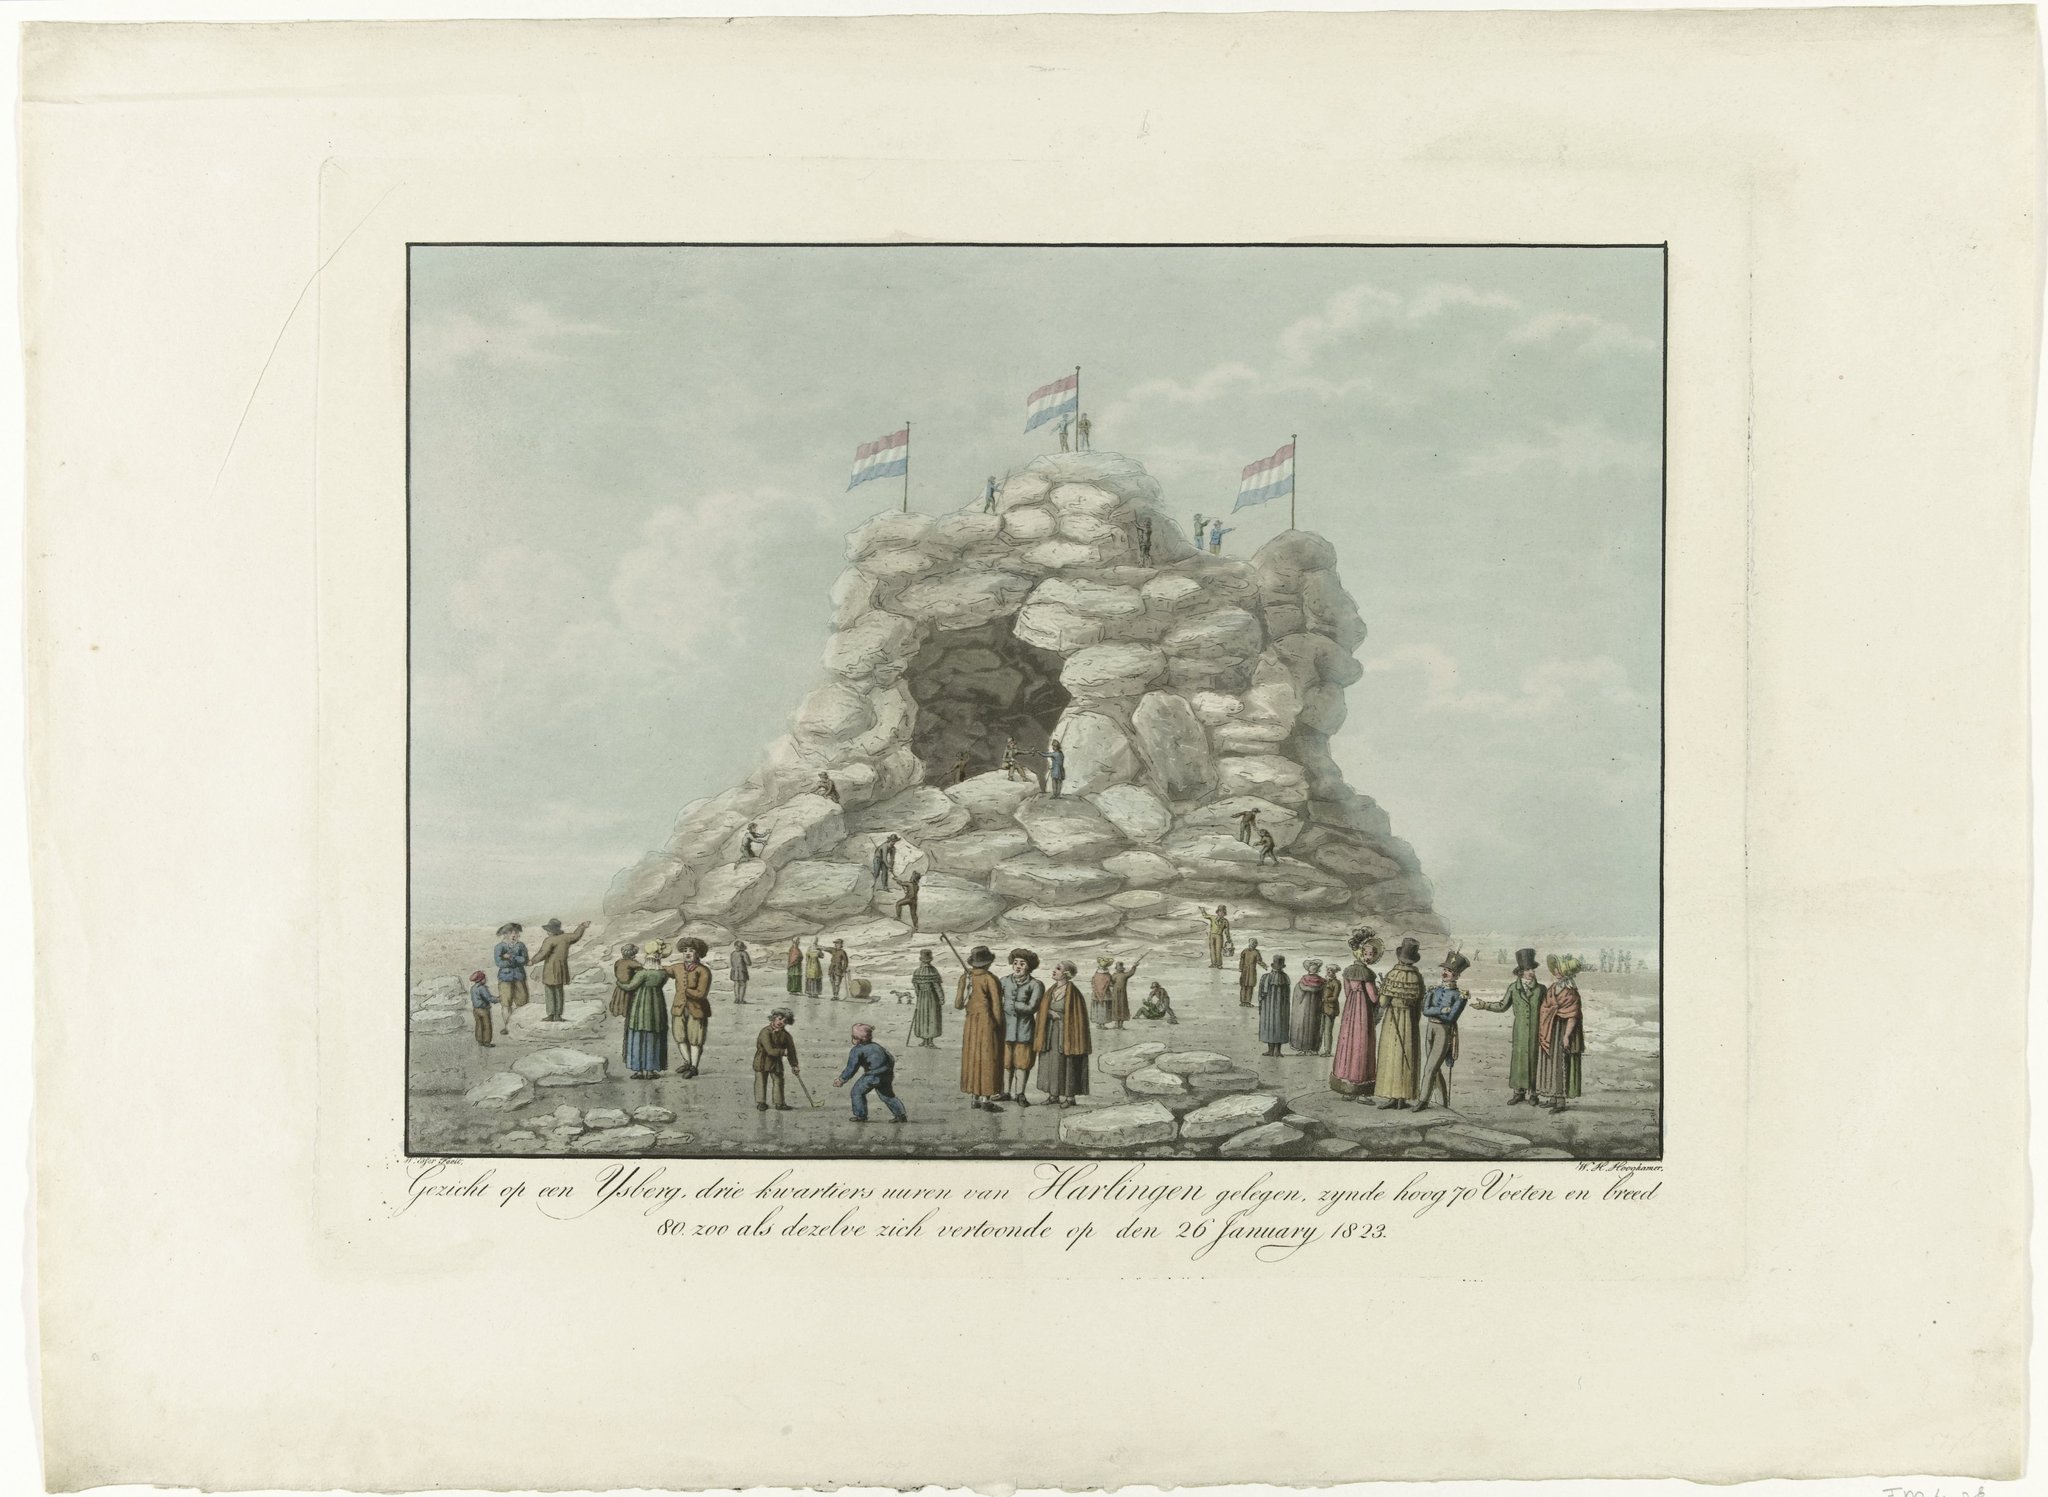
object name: print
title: IJsberg van kruiend ijs, 1823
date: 1823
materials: paper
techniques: aquatint, etching, hand coloring, lithography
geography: netherlands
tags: drift ice, harlingen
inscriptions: collector's mark: Lugt 2228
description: IJsberg van kruiend ijs in Friesland in de omgeving van Harlingen, 26 januari 1823. Op de ijsberg klimmen meerdere personen en prijken drie Nederlandse vlaggen. Op de voorgrond bezoekers op het ijs. Zie ook de pendant.